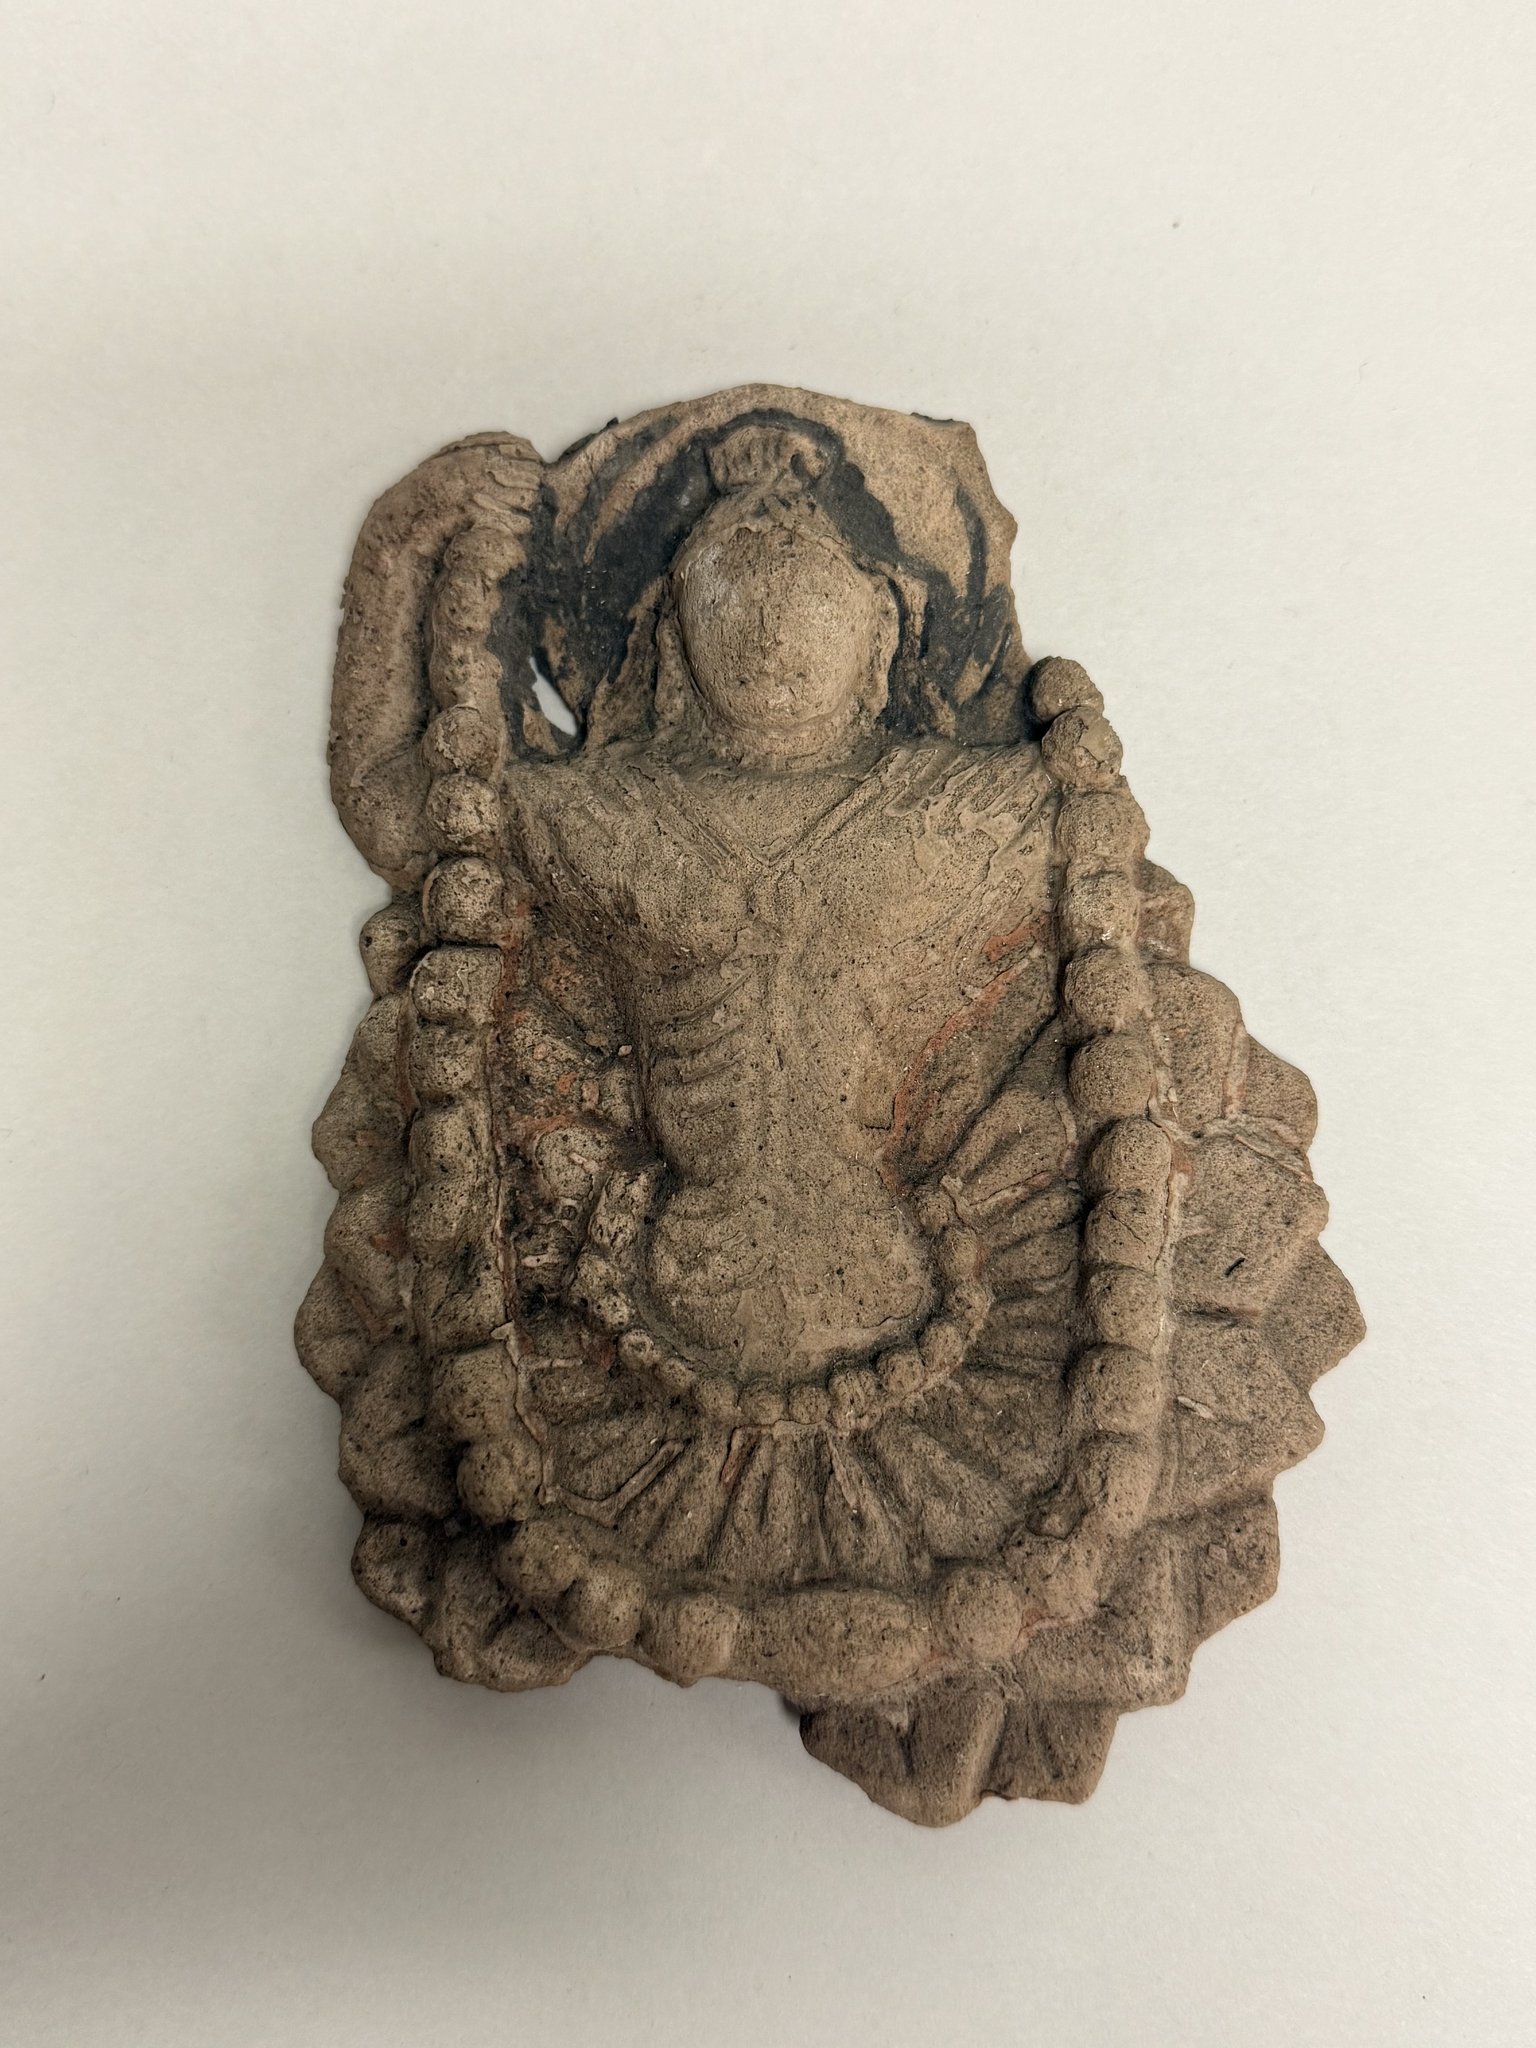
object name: relief fragment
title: Fragment of a Relief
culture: central asian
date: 701-800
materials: plaster